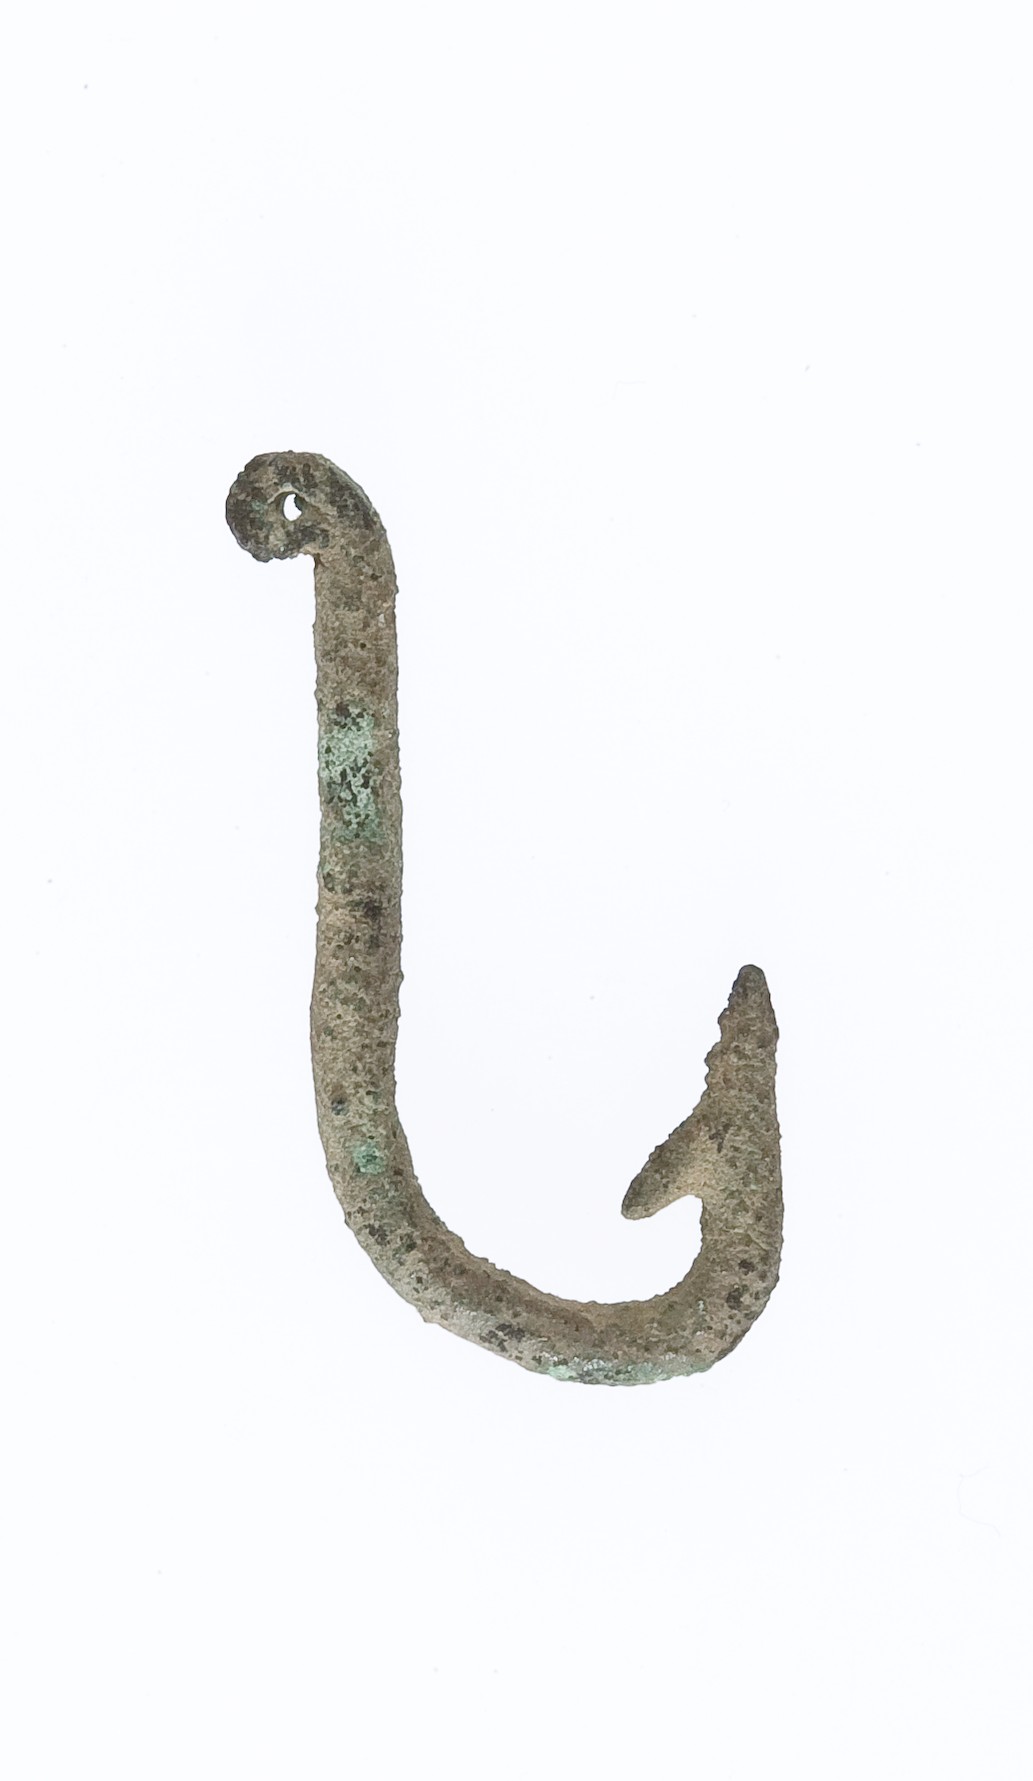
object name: fish hook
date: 1295-1070 BCE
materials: bronze, copper alloy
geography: egypt